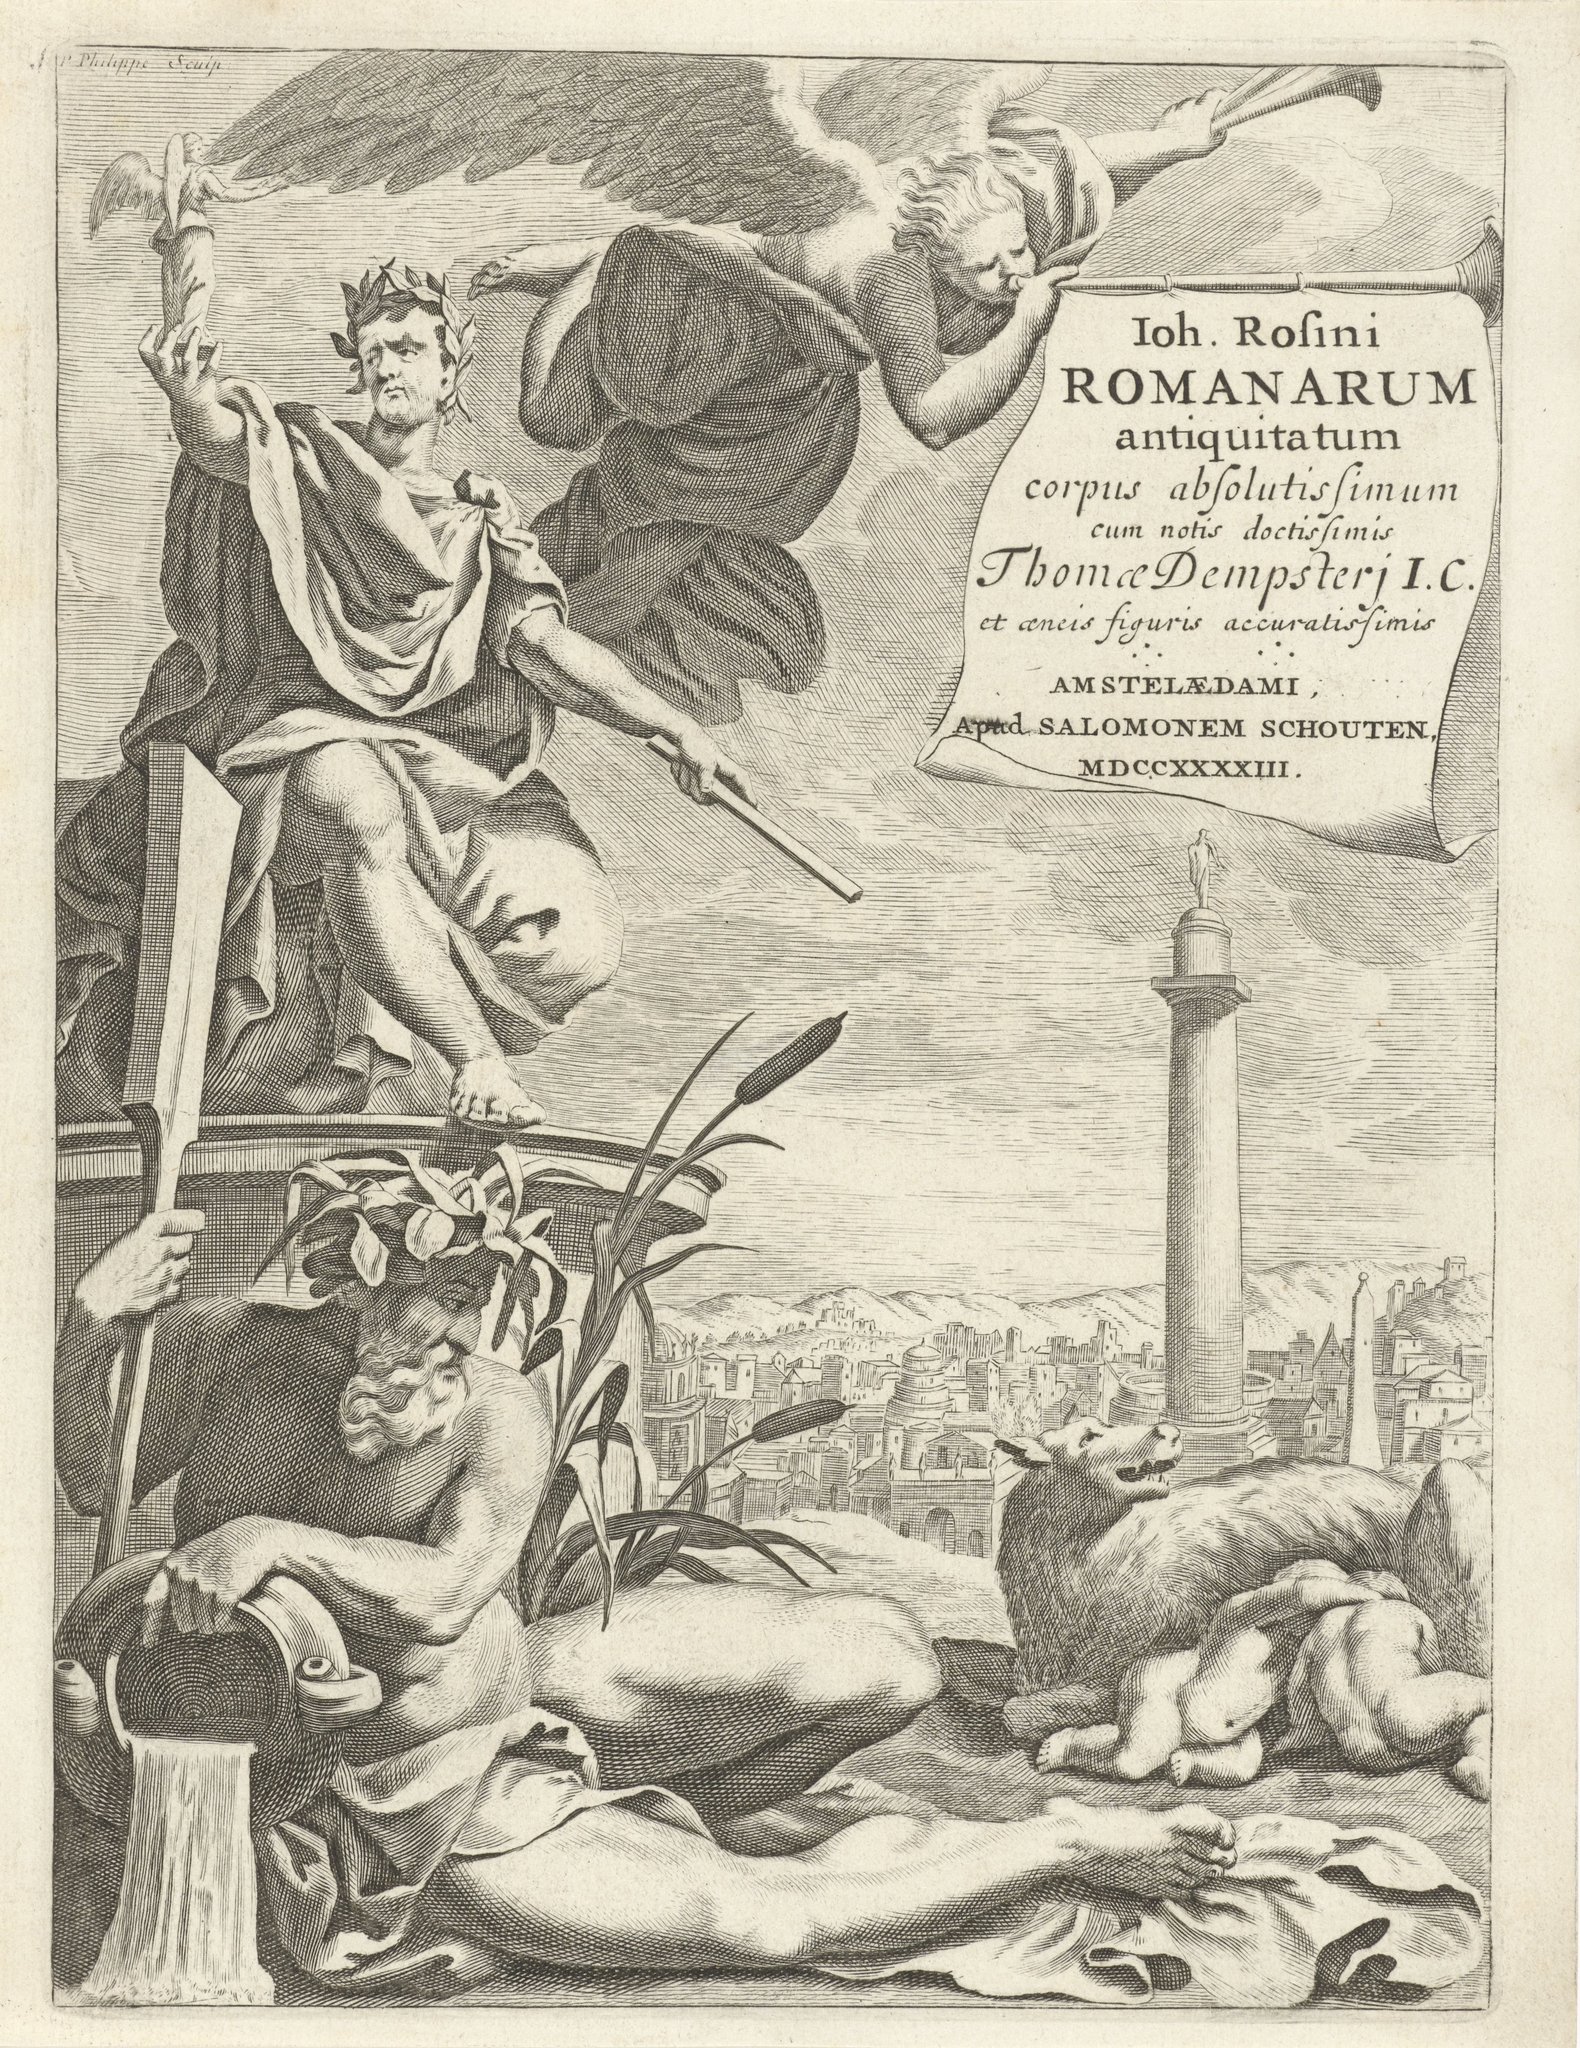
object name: titelblad, titelpagina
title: Allegorie op Rome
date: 1743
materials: paper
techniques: engraving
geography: amsterdam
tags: romulus and remus are washed ashore and suckled by a she-wolf; 'lupa romana', personification of river tiber; 'tevere' (ripa), emperor, rome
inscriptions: collector's mark: Lugt 2760, collector's mark: Lugt 2228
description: Figuren die de stad Rome symboliseren: op de voorgrond de riviergod Tiber en de wolf die Remus en Romulus zoogt, op een piëdestal een standbeeld van een Romeinse keizer. Op de achtergrond een gezicht op Rome. Een engel blaast op een bazuin waaraan een doek hangt met de titel in het Latijn.